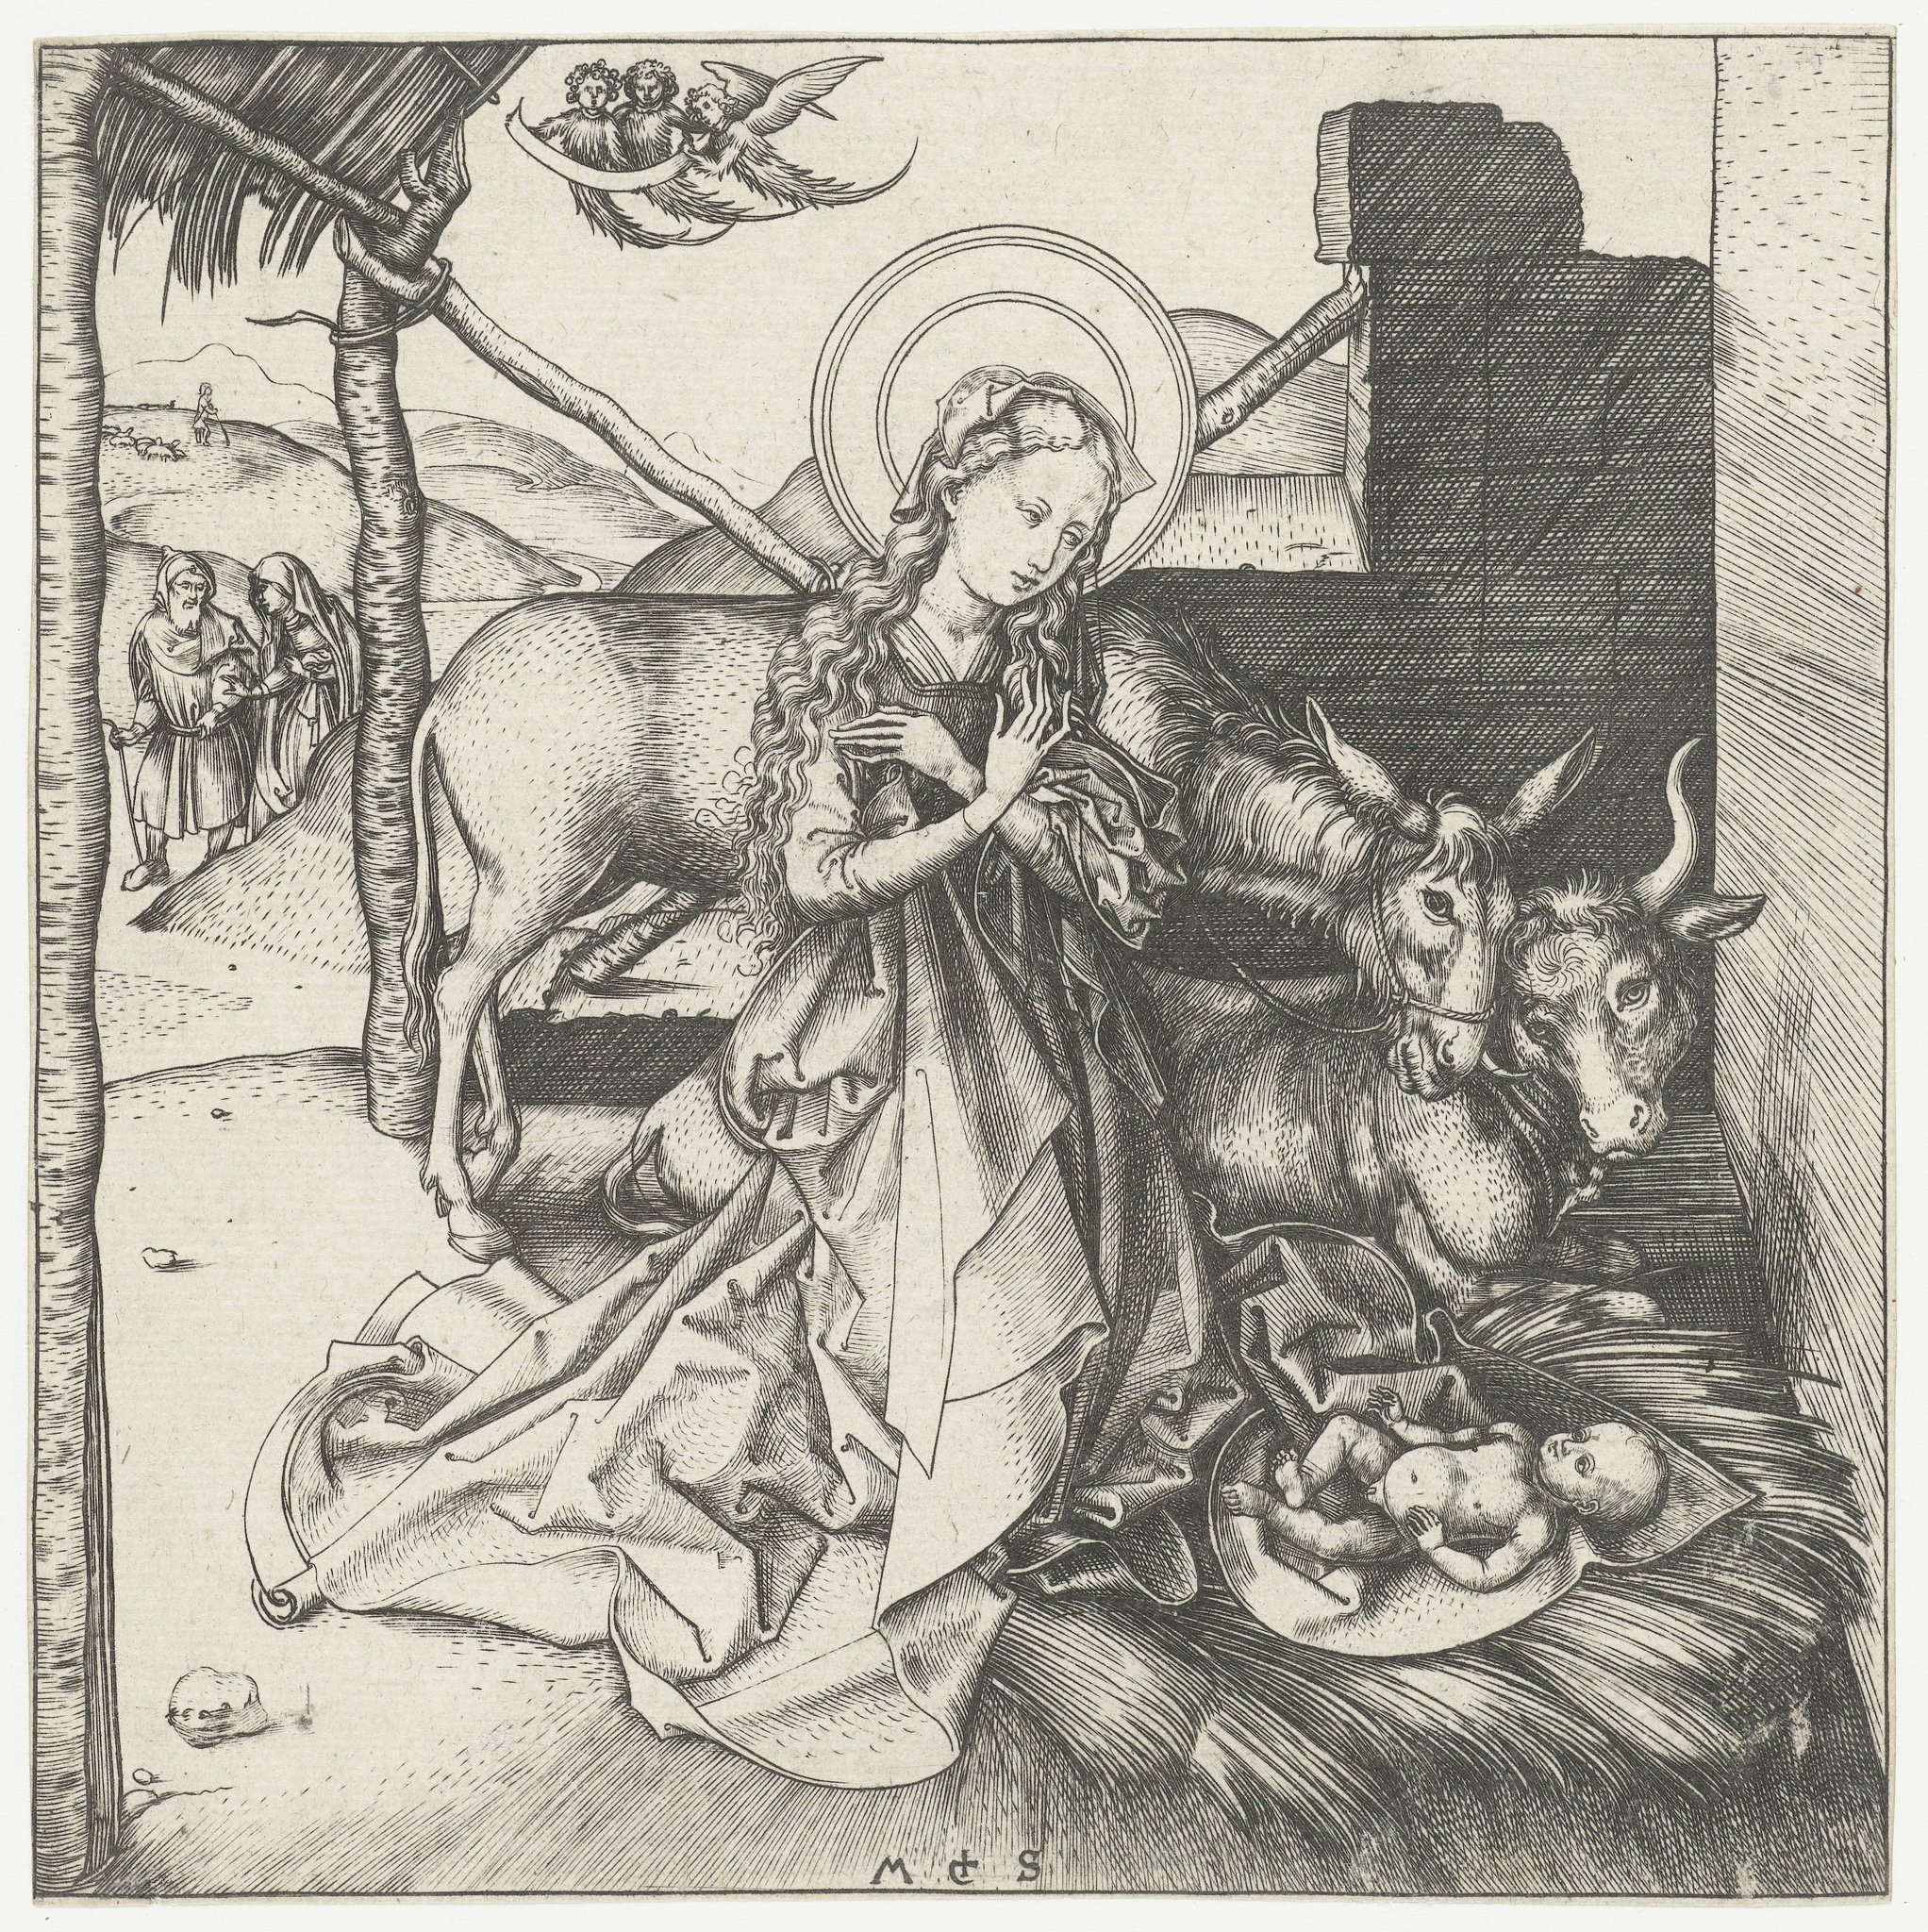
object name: print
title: De geboorte van Christus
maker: martin schongauer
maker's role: print maker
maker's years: 1430-1491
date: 1470-1491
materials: paper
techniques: engraving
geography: germany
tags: adoration of the christ-child by mary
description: In een vervallen gebouwtje knielt Maria bij het Christuskind. Een os en een ezel kijken toe. Jozef komt links aanlopen met een vrouw (een vroedvrouw?). In de lucht drie engelen.